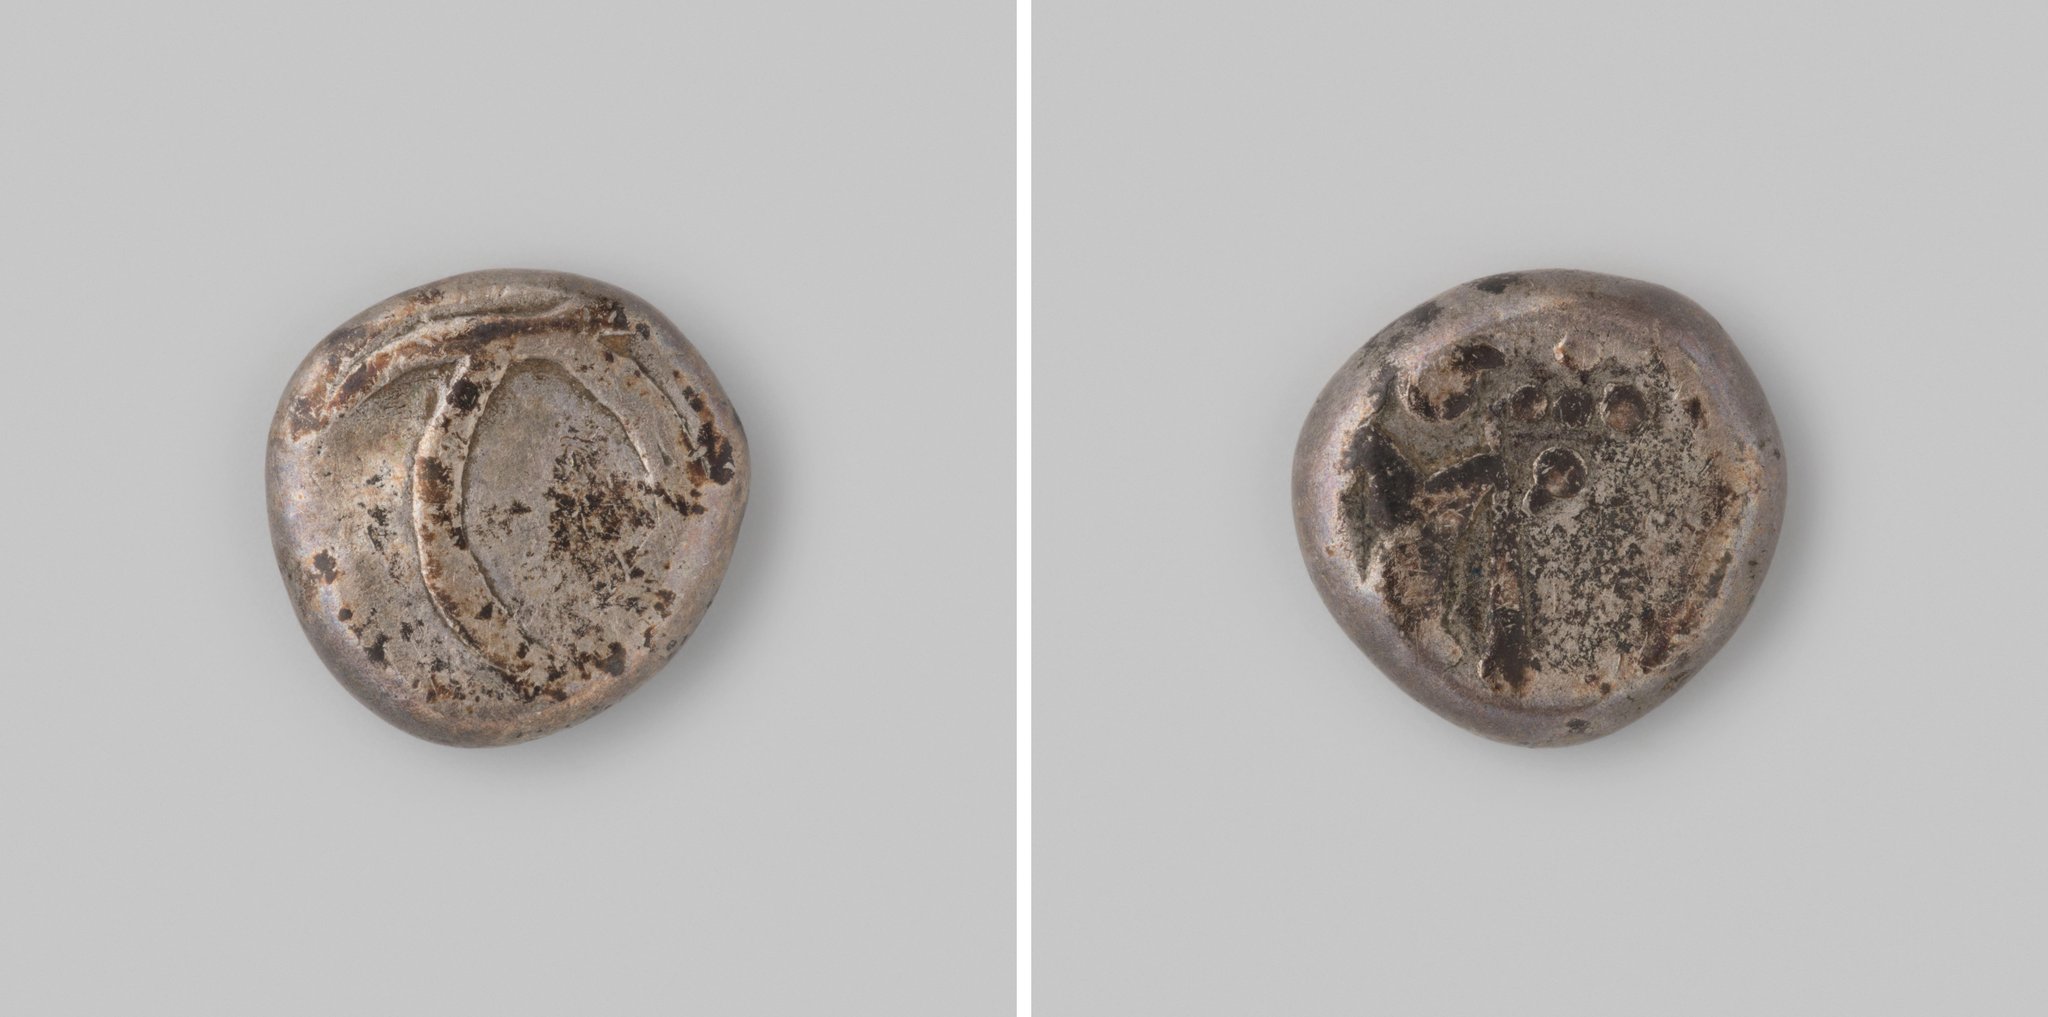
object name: coin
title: Zilveren dubbele fanam uit Madras in Brits Indië onder de East India Company,1764-1807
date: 1764-1807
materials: silver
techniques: striking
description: Zilveren munt. Voorzijde: afbeelding van de Godheid Vishnu. Keerzijde: twee naar elkaar gewende en in elkaar verstrengelde letters C [=Company].